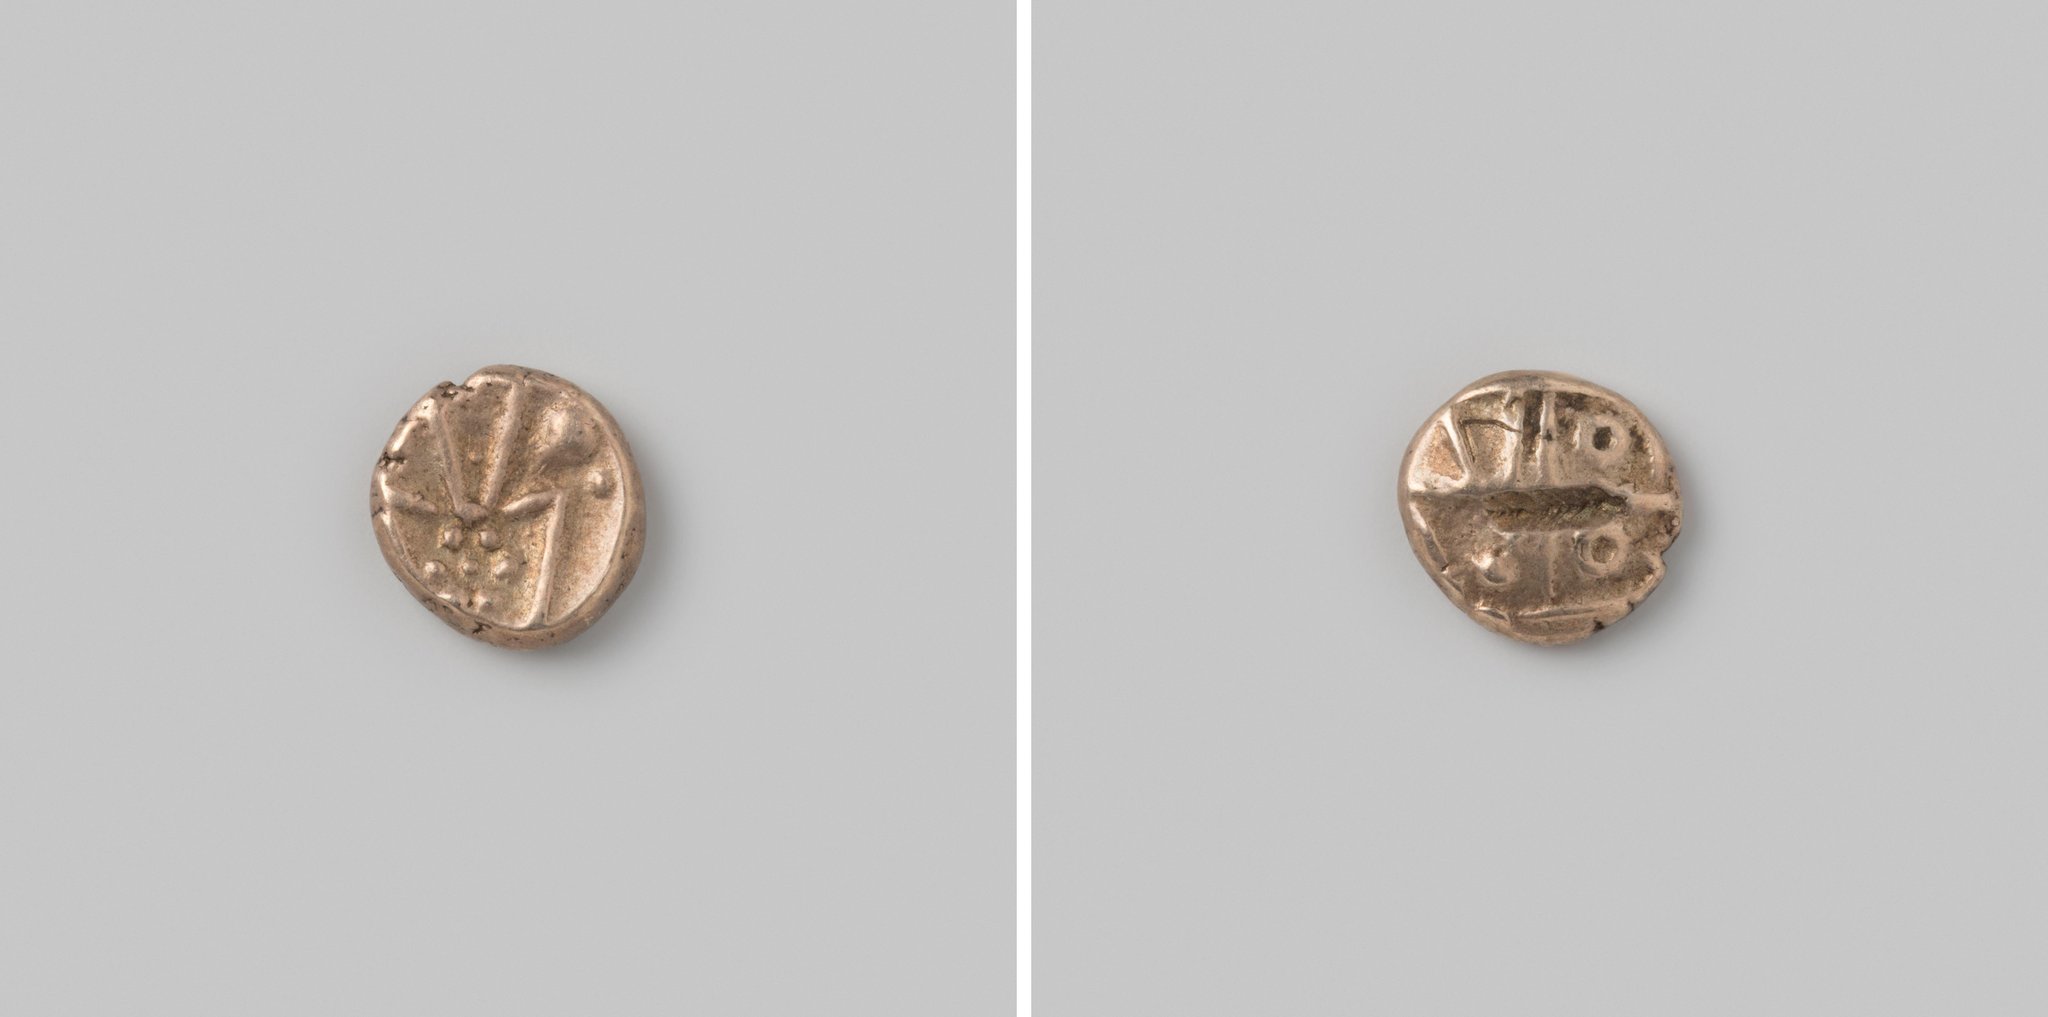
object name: coin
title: Gouden fanam uit Mysore in India van Kanthirava Narasa raja Wodeyar I, 1638-1659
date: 1638-1659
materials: gold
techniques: striking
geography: mysore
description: Gouden munt. Voorzijde: figuur, waaromheen stippen. Keerzijde: ondetermineerbare tekens.